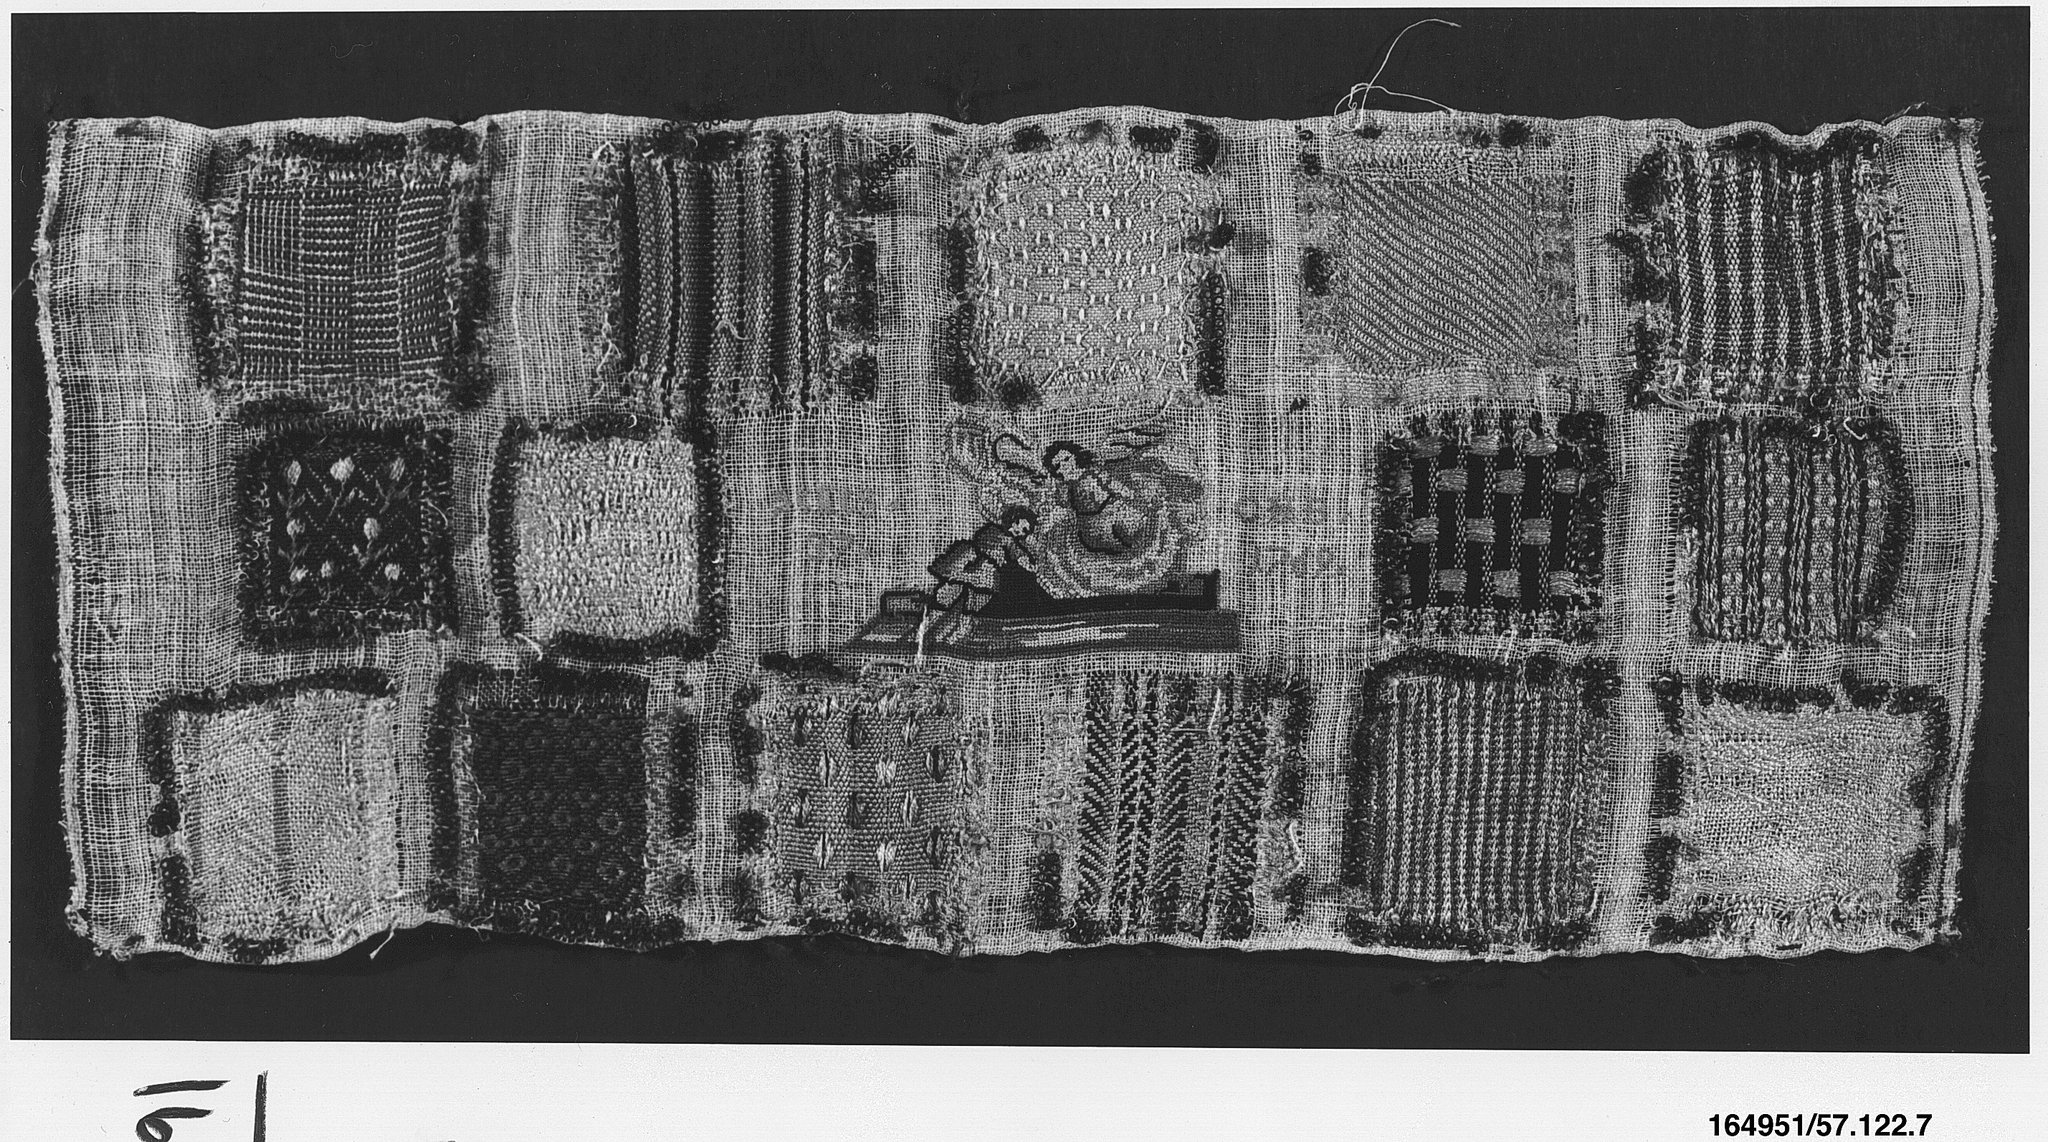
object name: sampler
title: Embroidered darning sampler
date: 1769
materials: canvas, metal thread, silk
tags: human figures